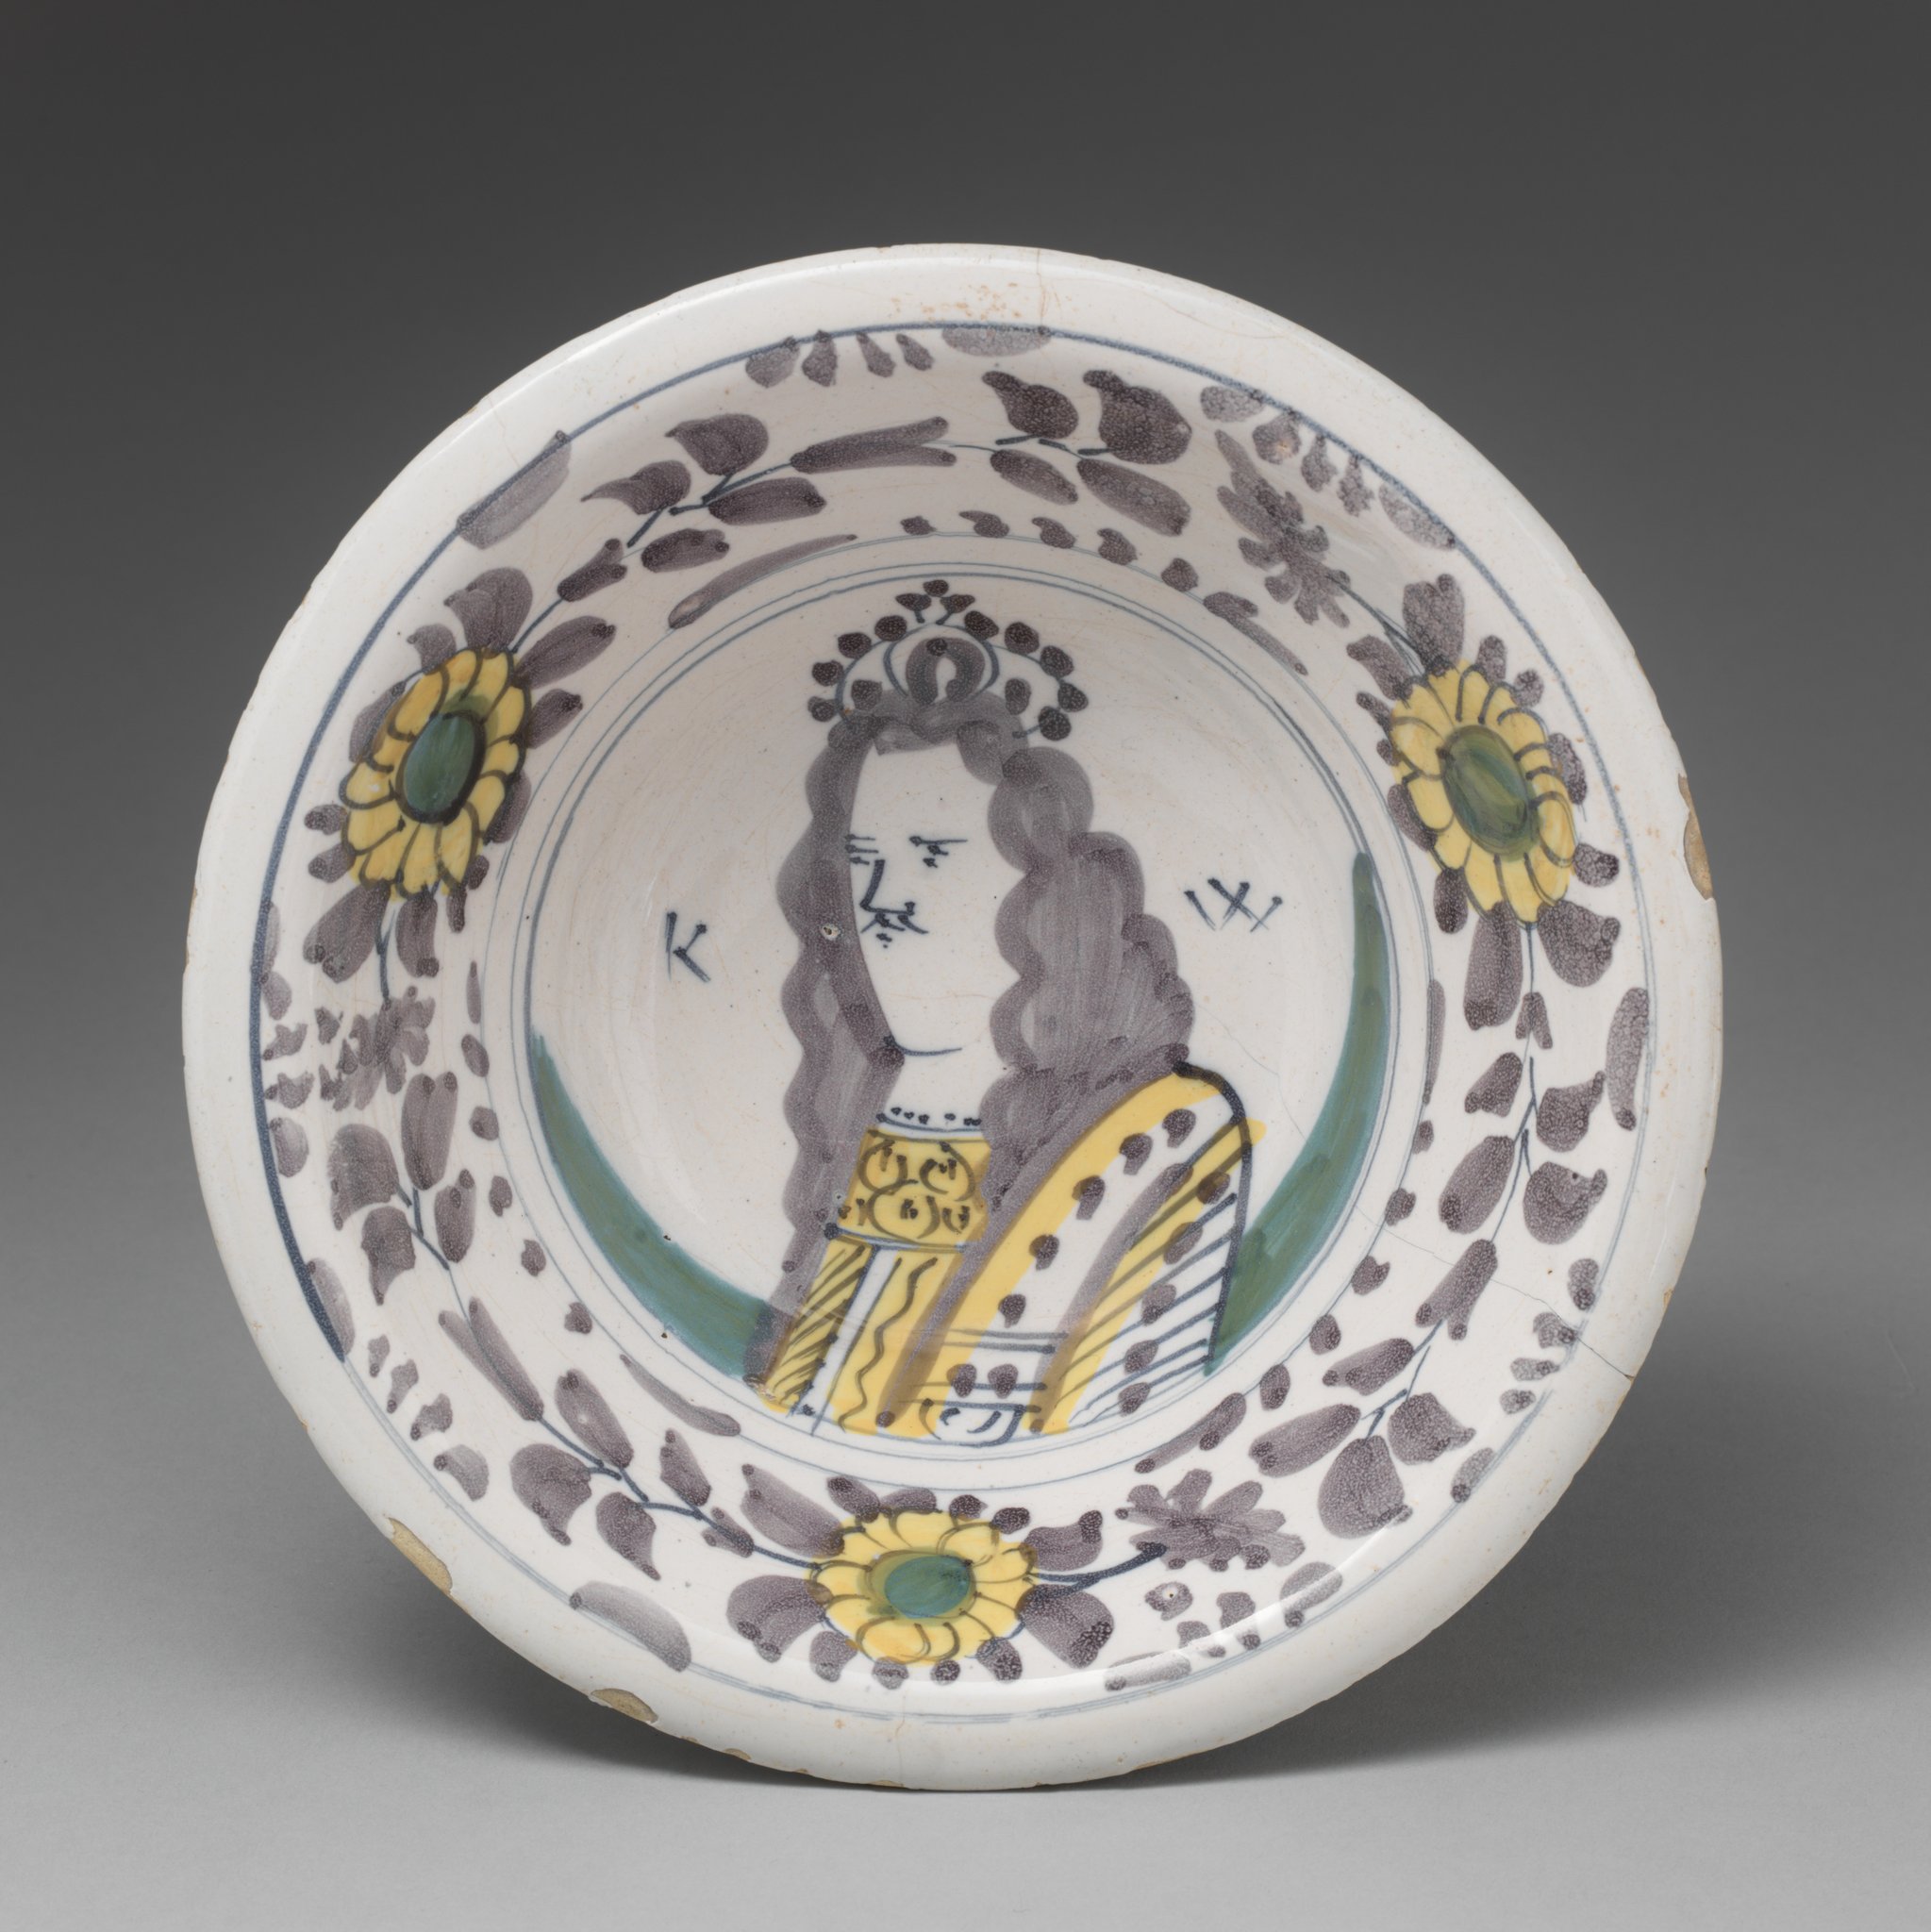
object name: bowl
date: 1700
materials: earthenware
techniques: glazing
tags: kings,men,portraits